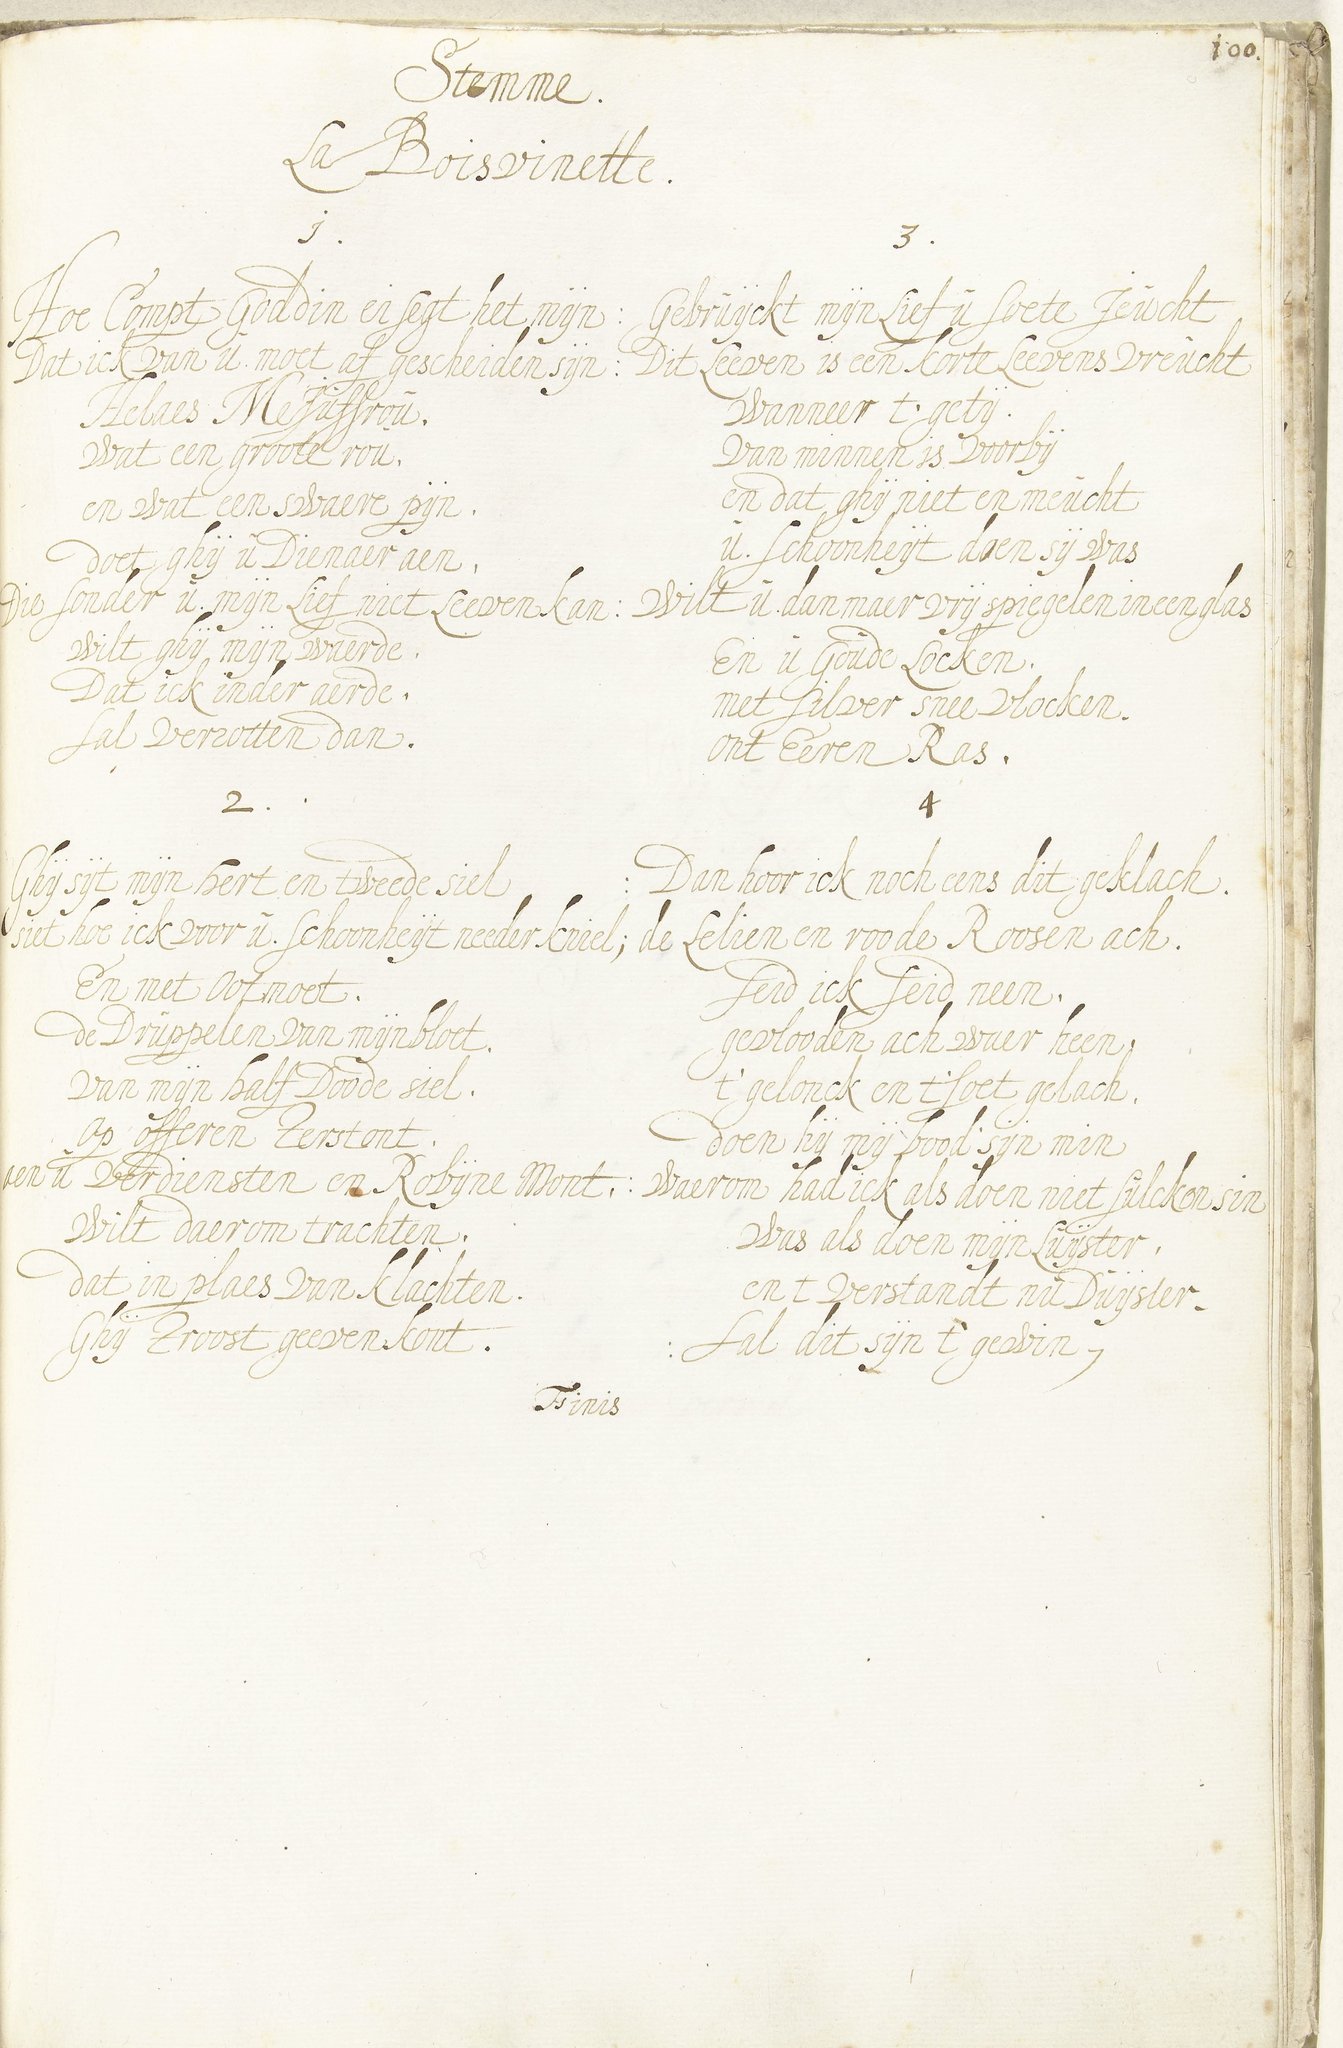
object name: poem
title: Liefdesklacht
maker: gesina ter borch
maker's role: draughtsman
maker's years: 1633-1690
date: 1659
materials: ink, paper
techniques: calligraphy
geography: zwolle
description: Liefdesklacht op de melodie van La Boisvinette.